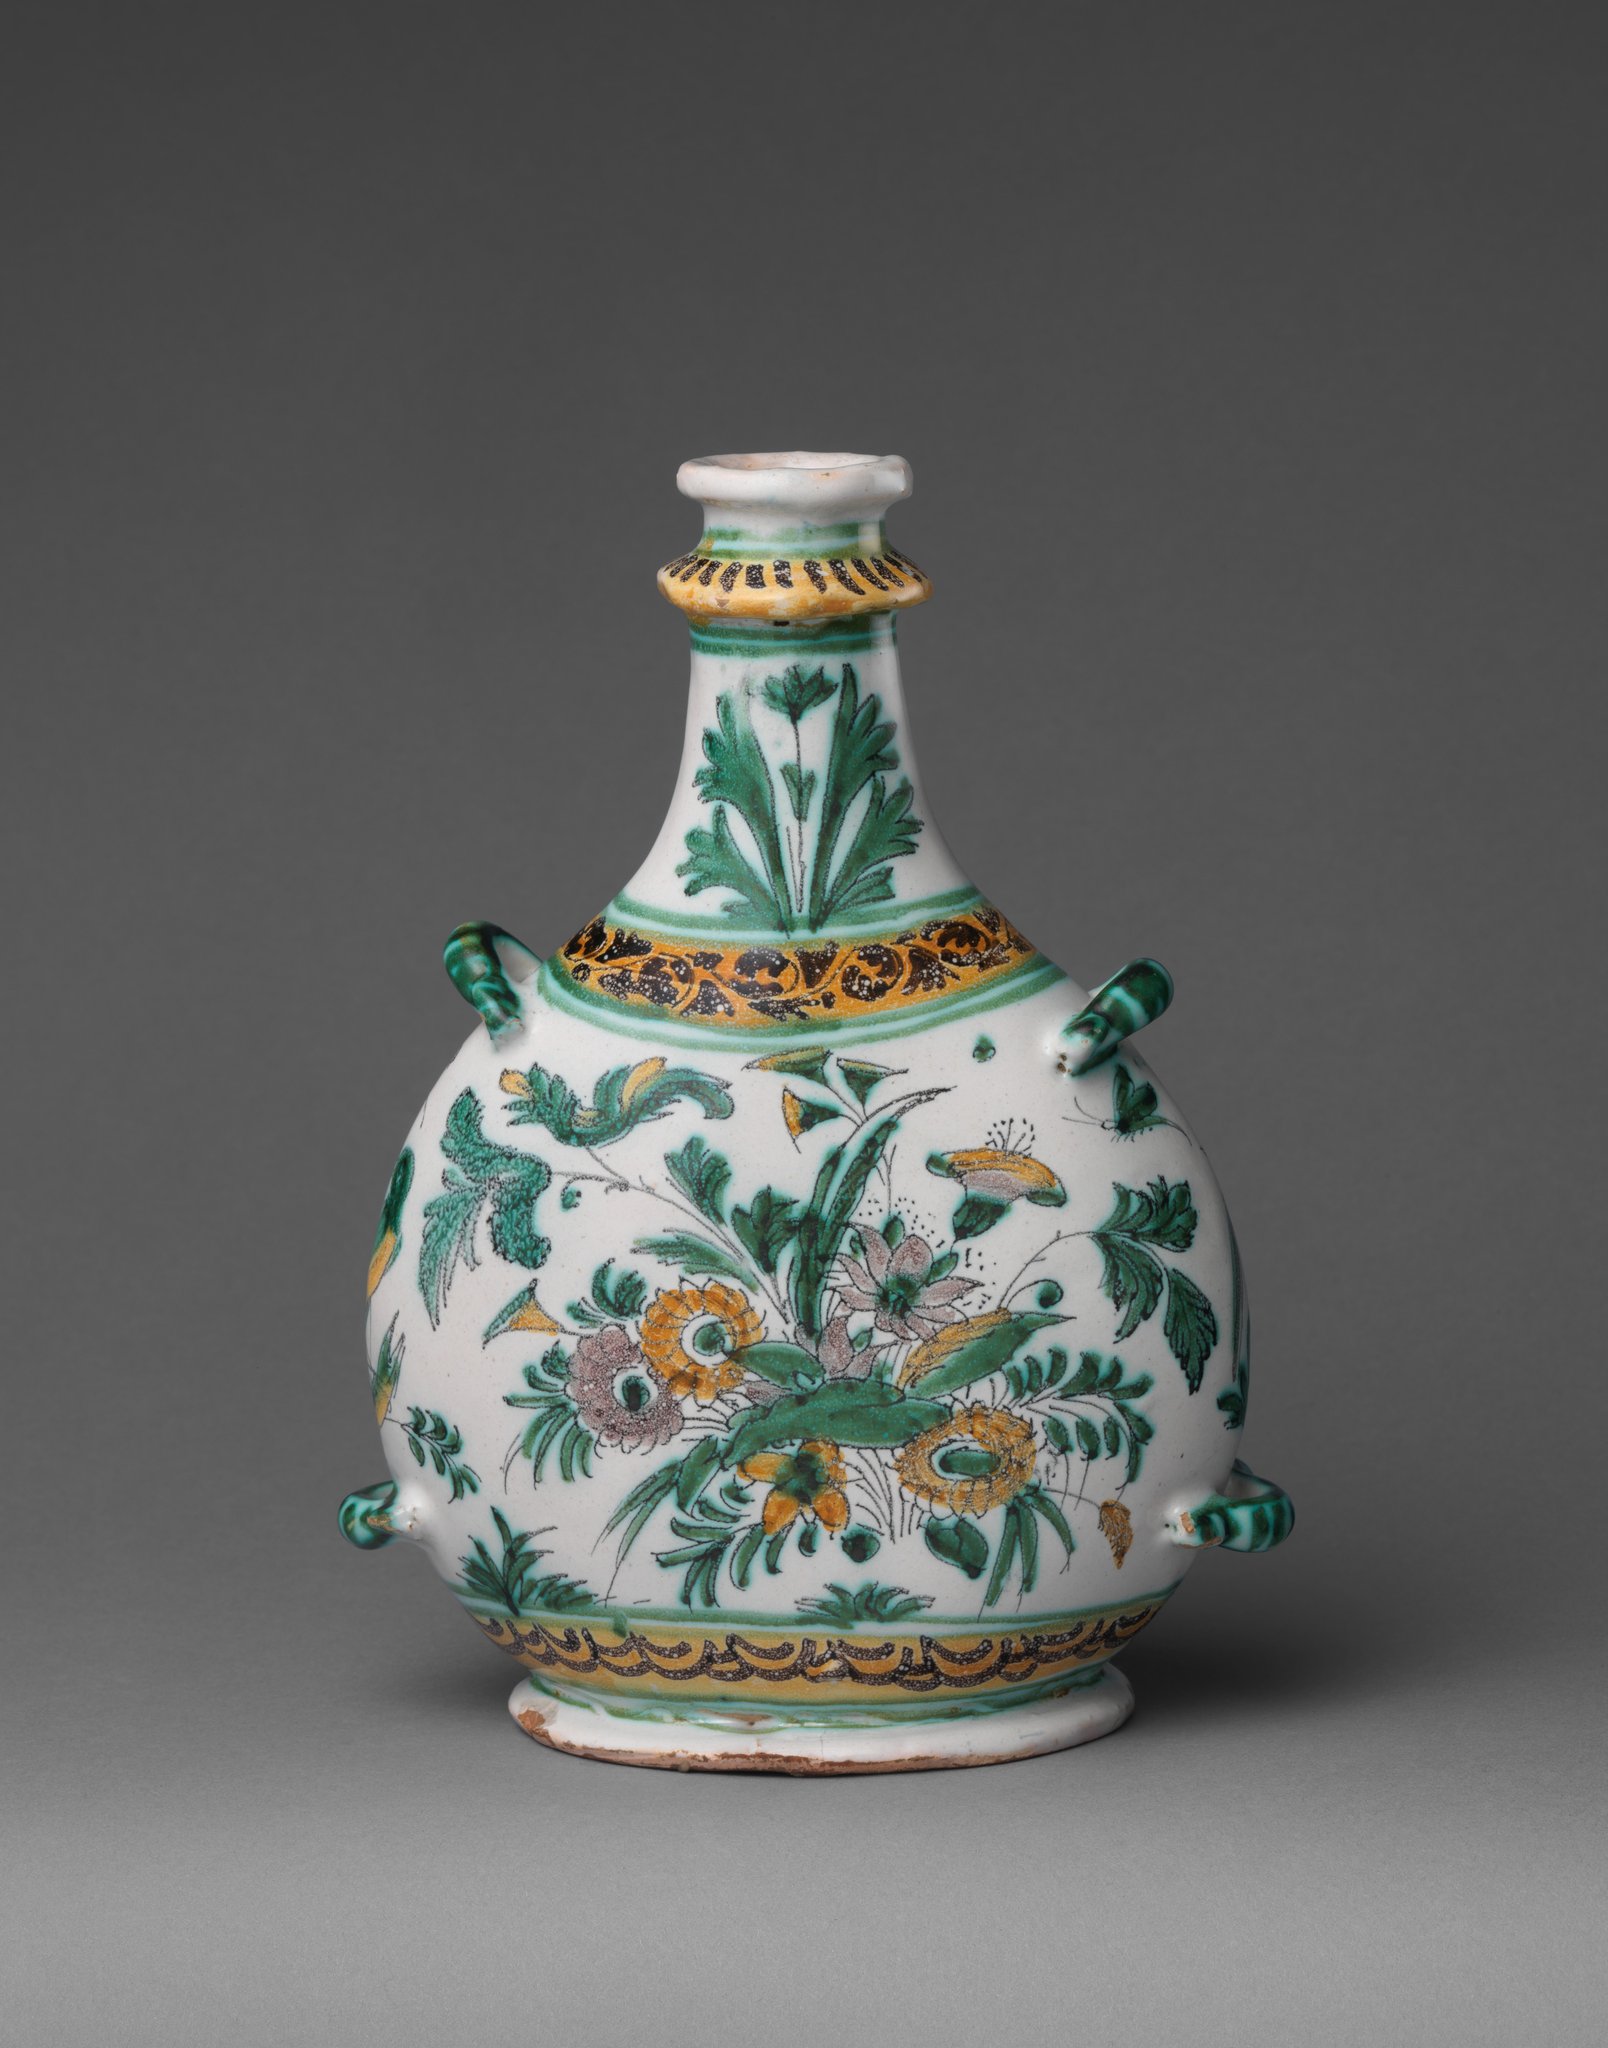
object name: pilgrim bottle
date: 1650-1675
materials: faience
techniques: glazing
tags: birds,flowers